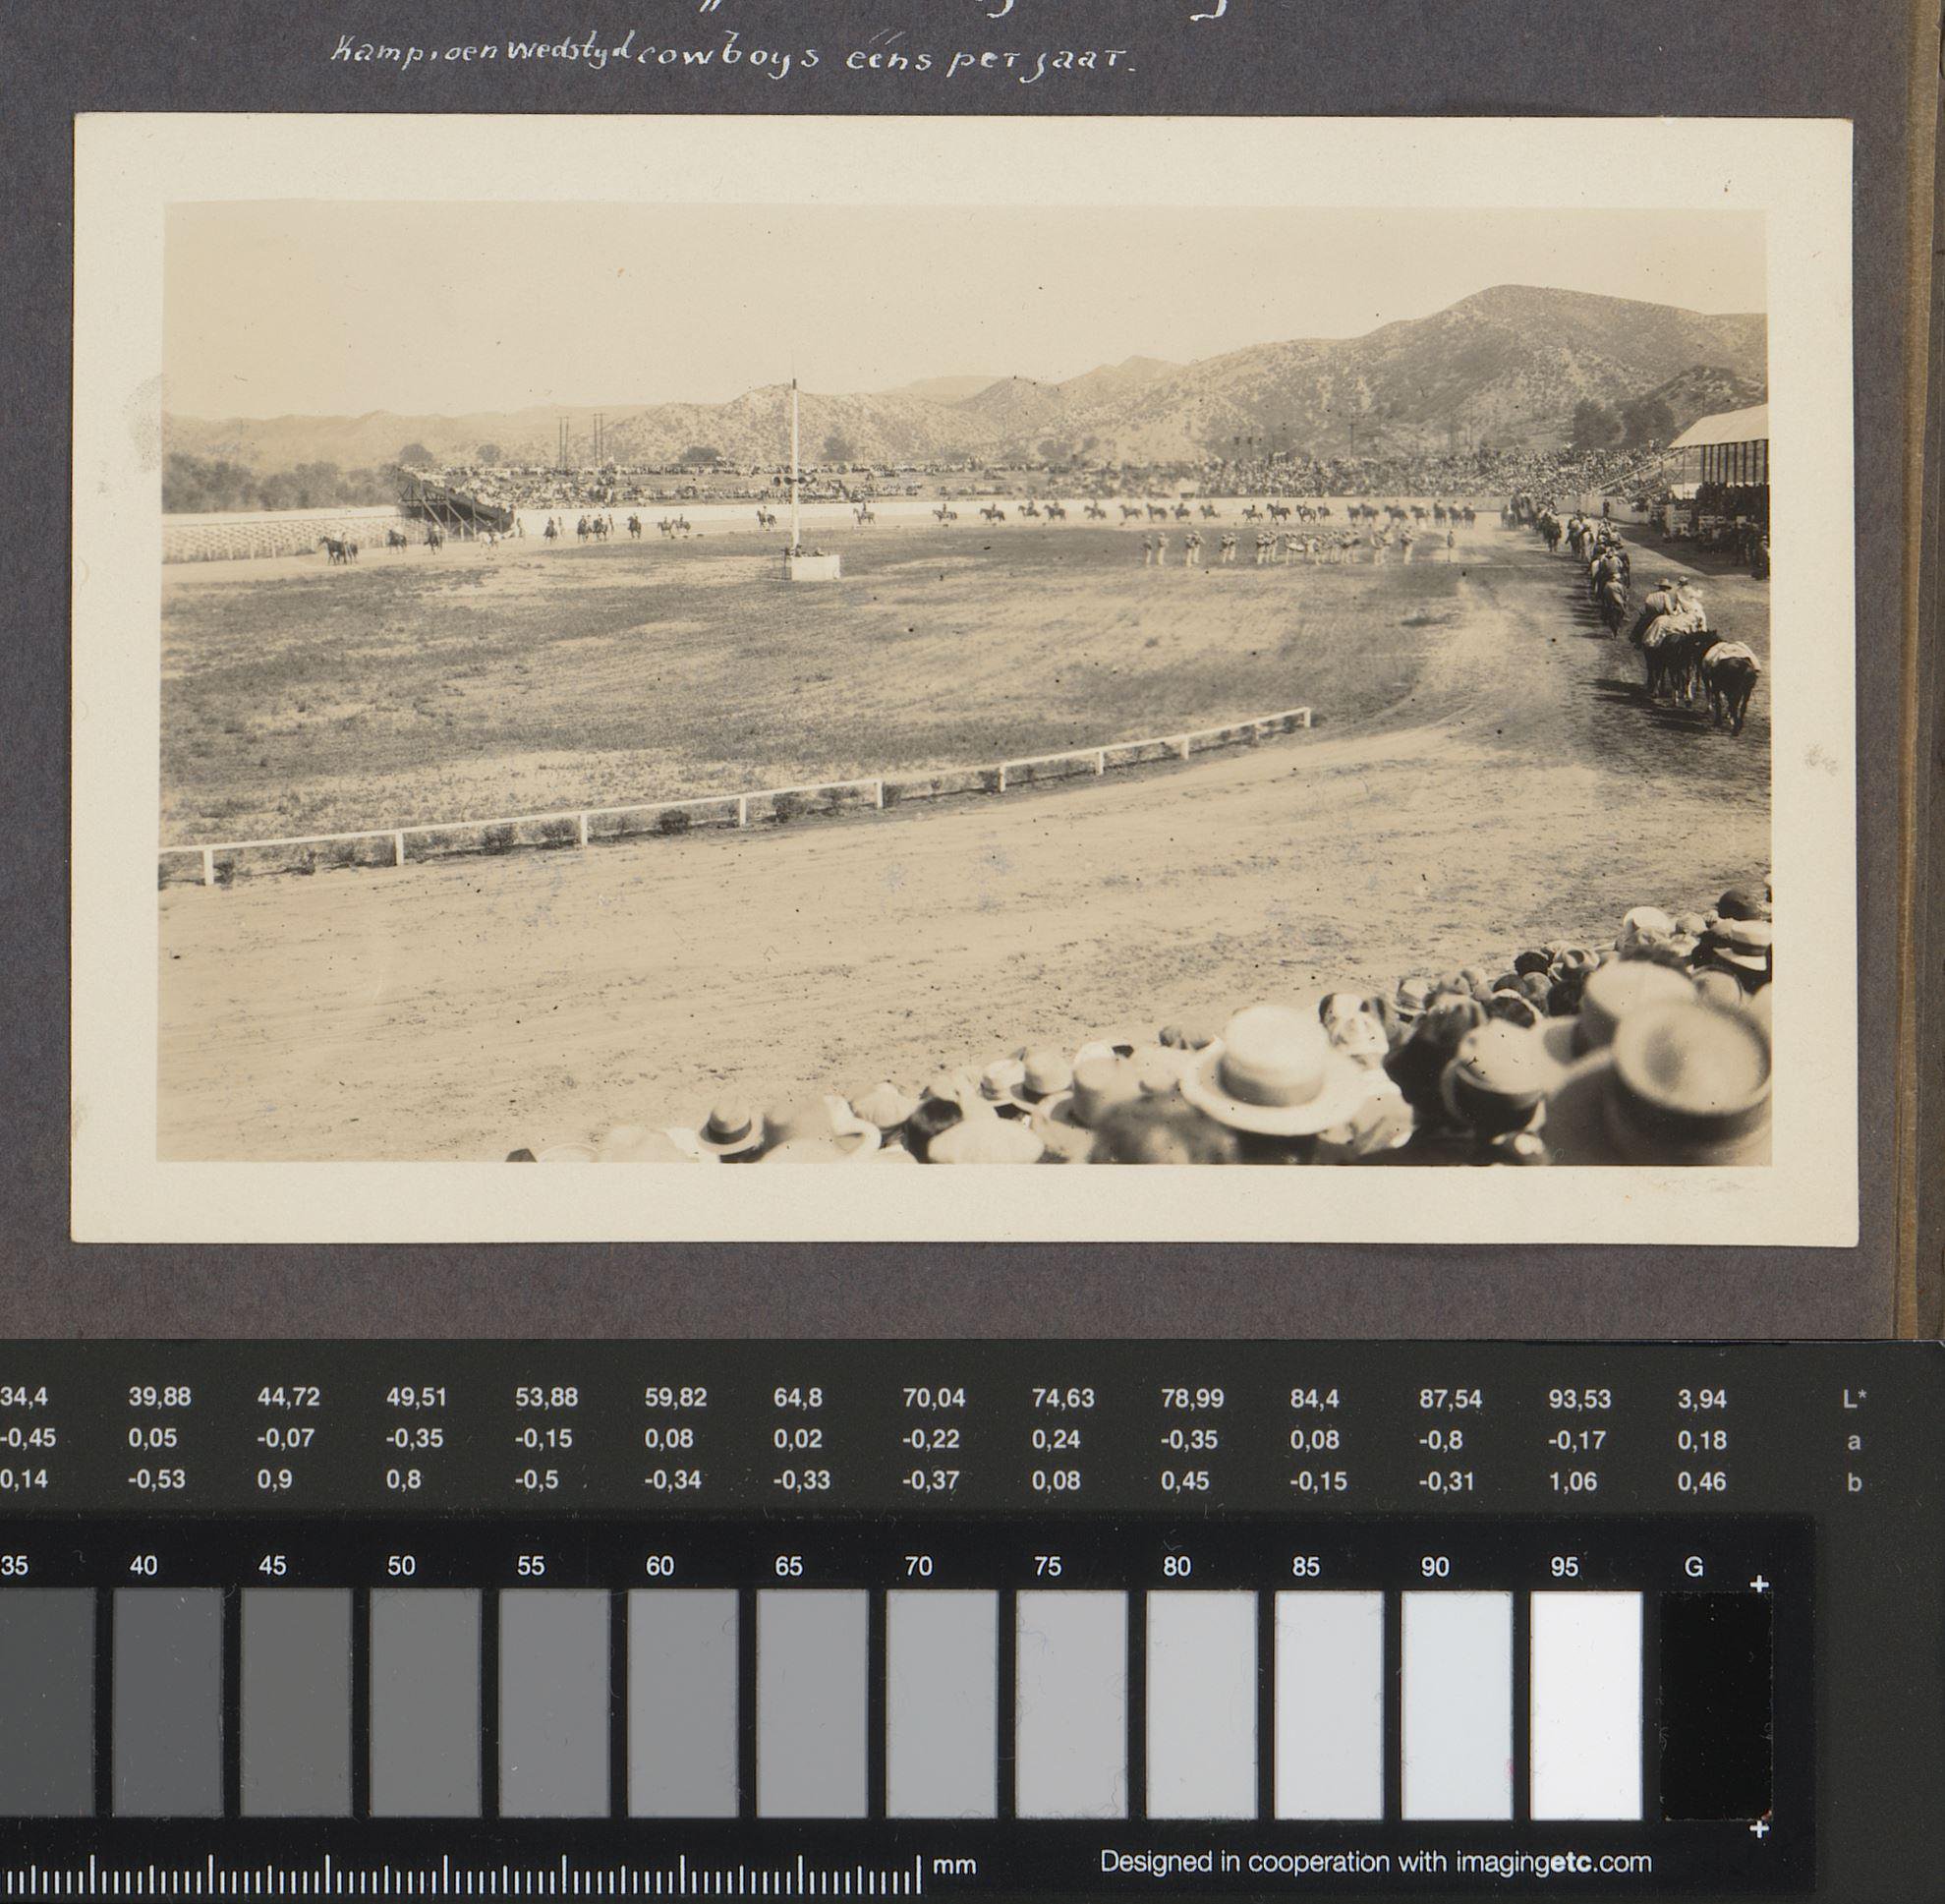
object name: album leaf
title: Rodeo bij Baker Ranch in de omgeving van Saugus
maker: Anonymous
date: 1928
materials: photographic support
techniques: gelatin silver print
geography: saugus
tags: historical persons, the audience ~ art performance, rodeo, horse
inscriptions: annotation: ‘Baker Ranch "Rodeo" bij Saugus/ Kampioenwedstrijd cowboys ééns per jaar’